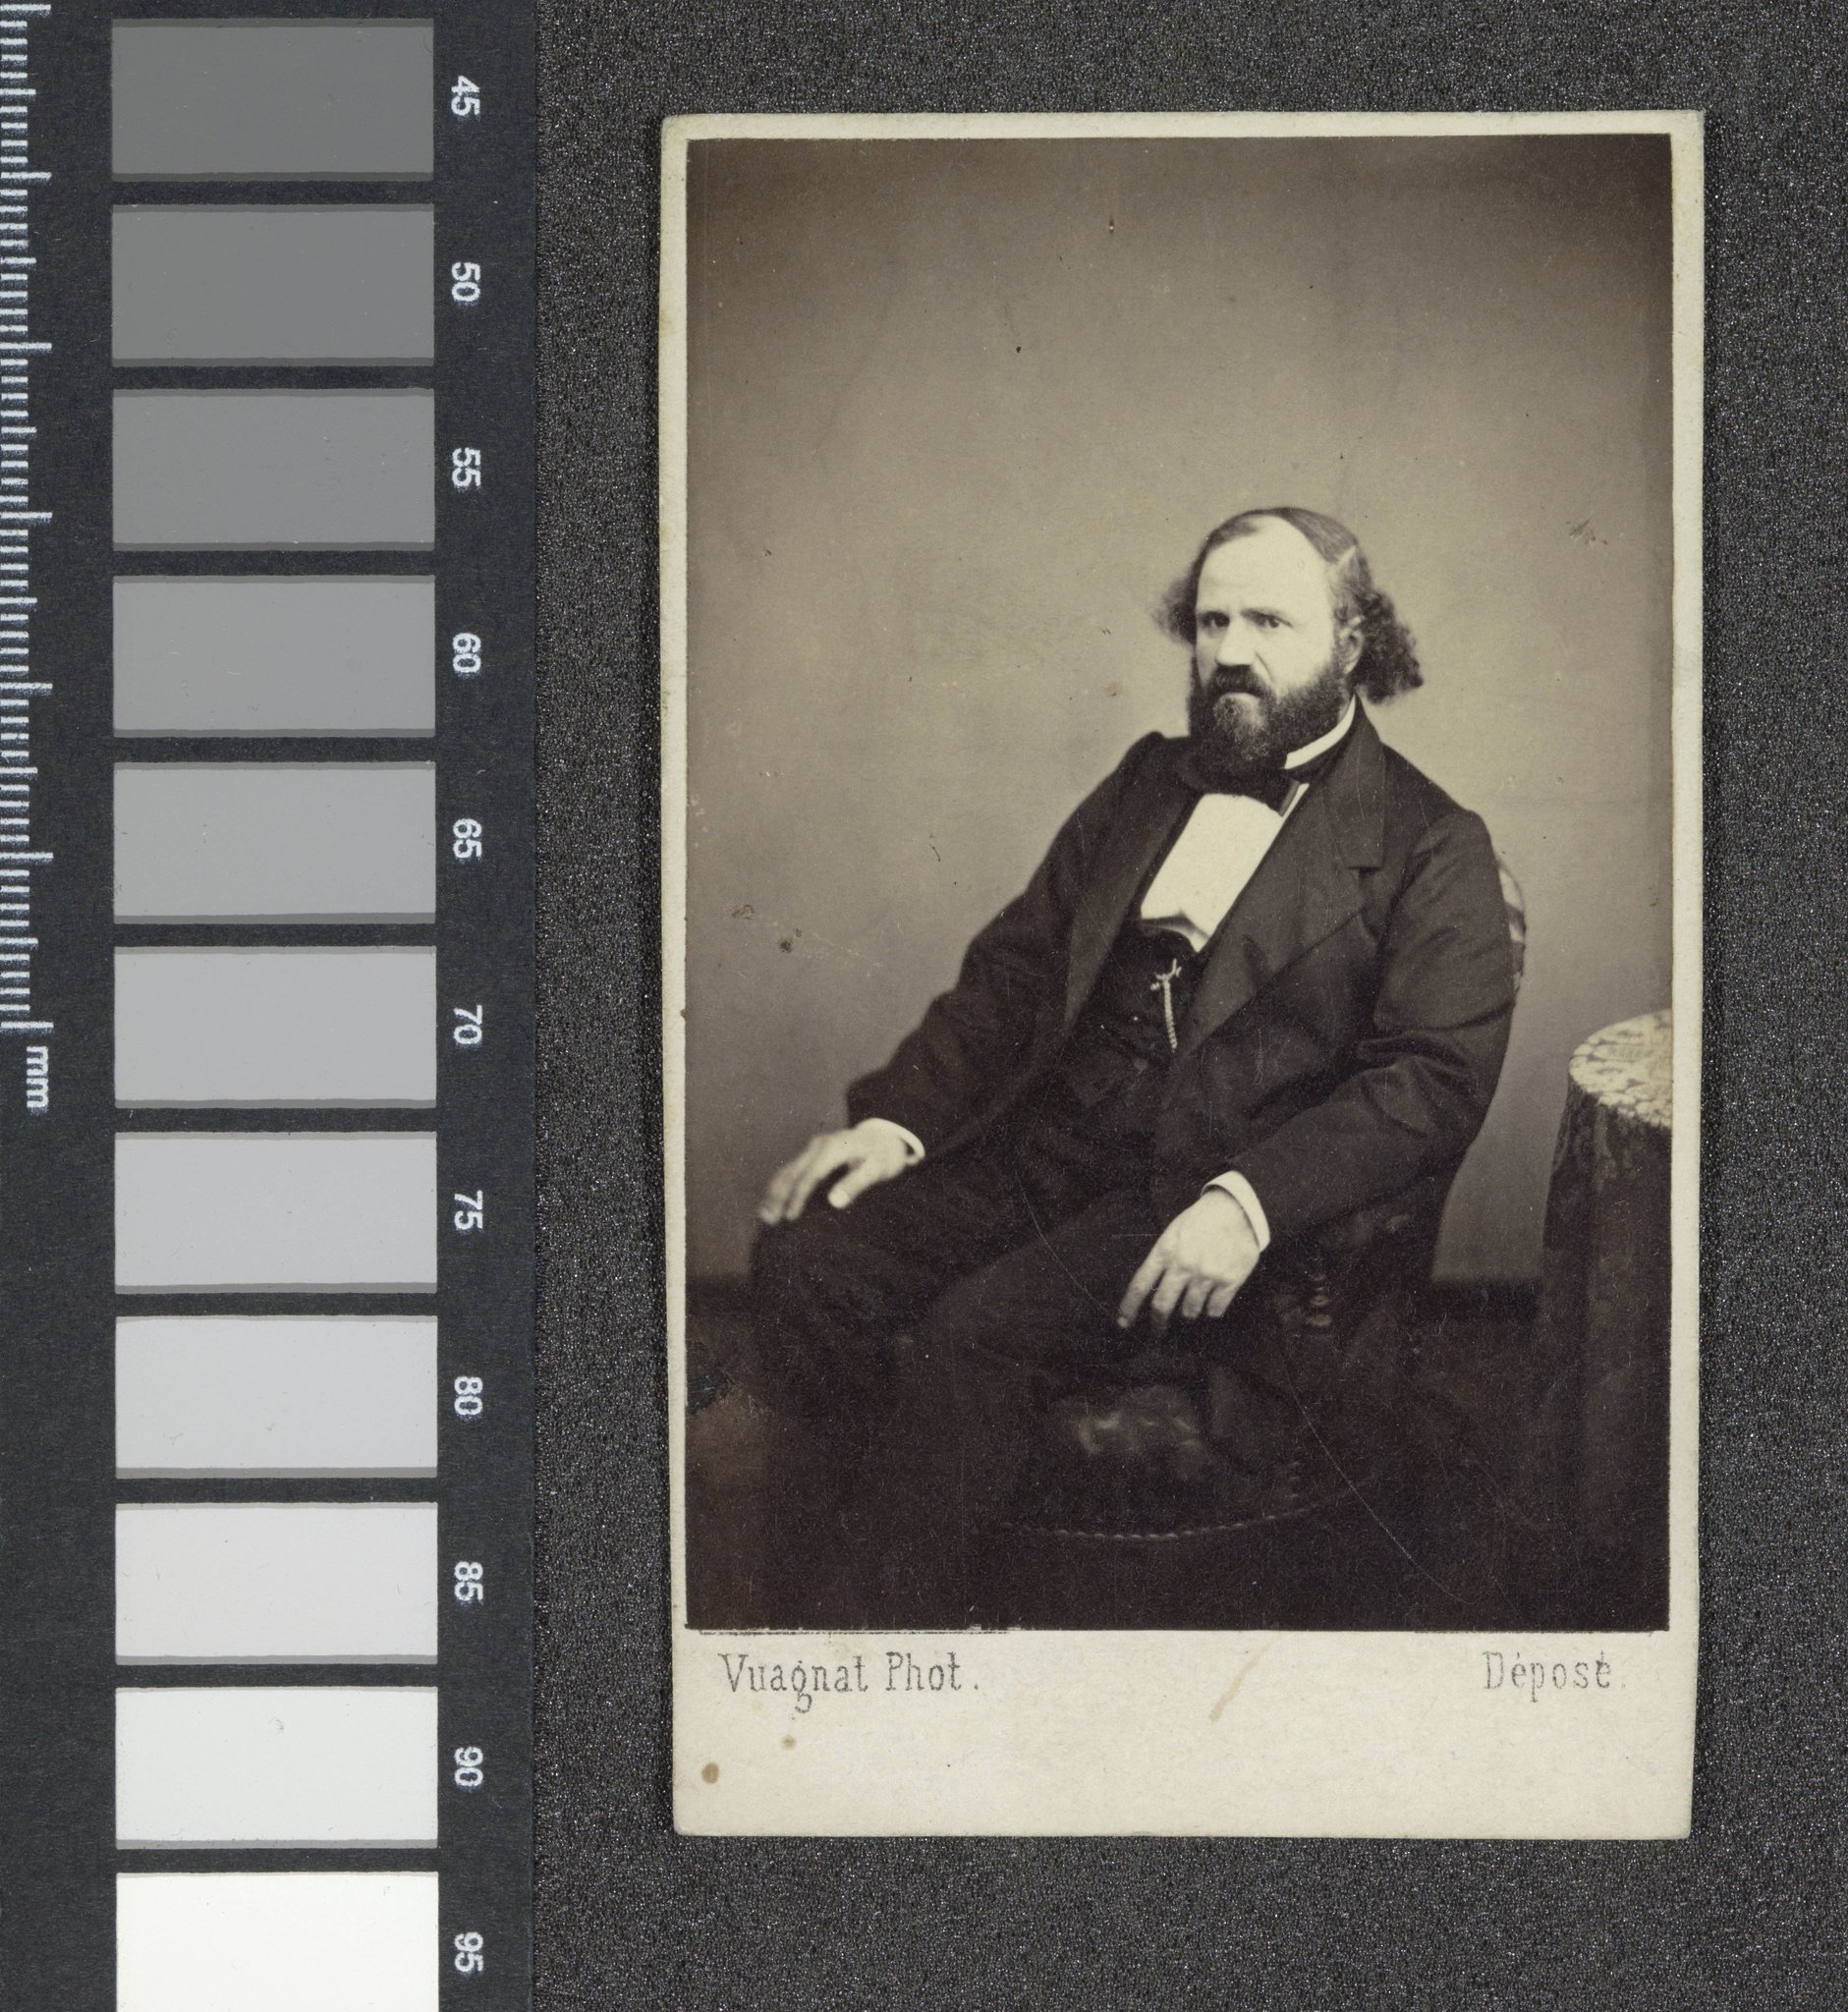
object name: carte de visite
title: Portret van een onbekende man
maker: vuagnat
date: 1860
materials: cardboard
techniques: albumen print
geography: geneva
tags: historical persons not known by name